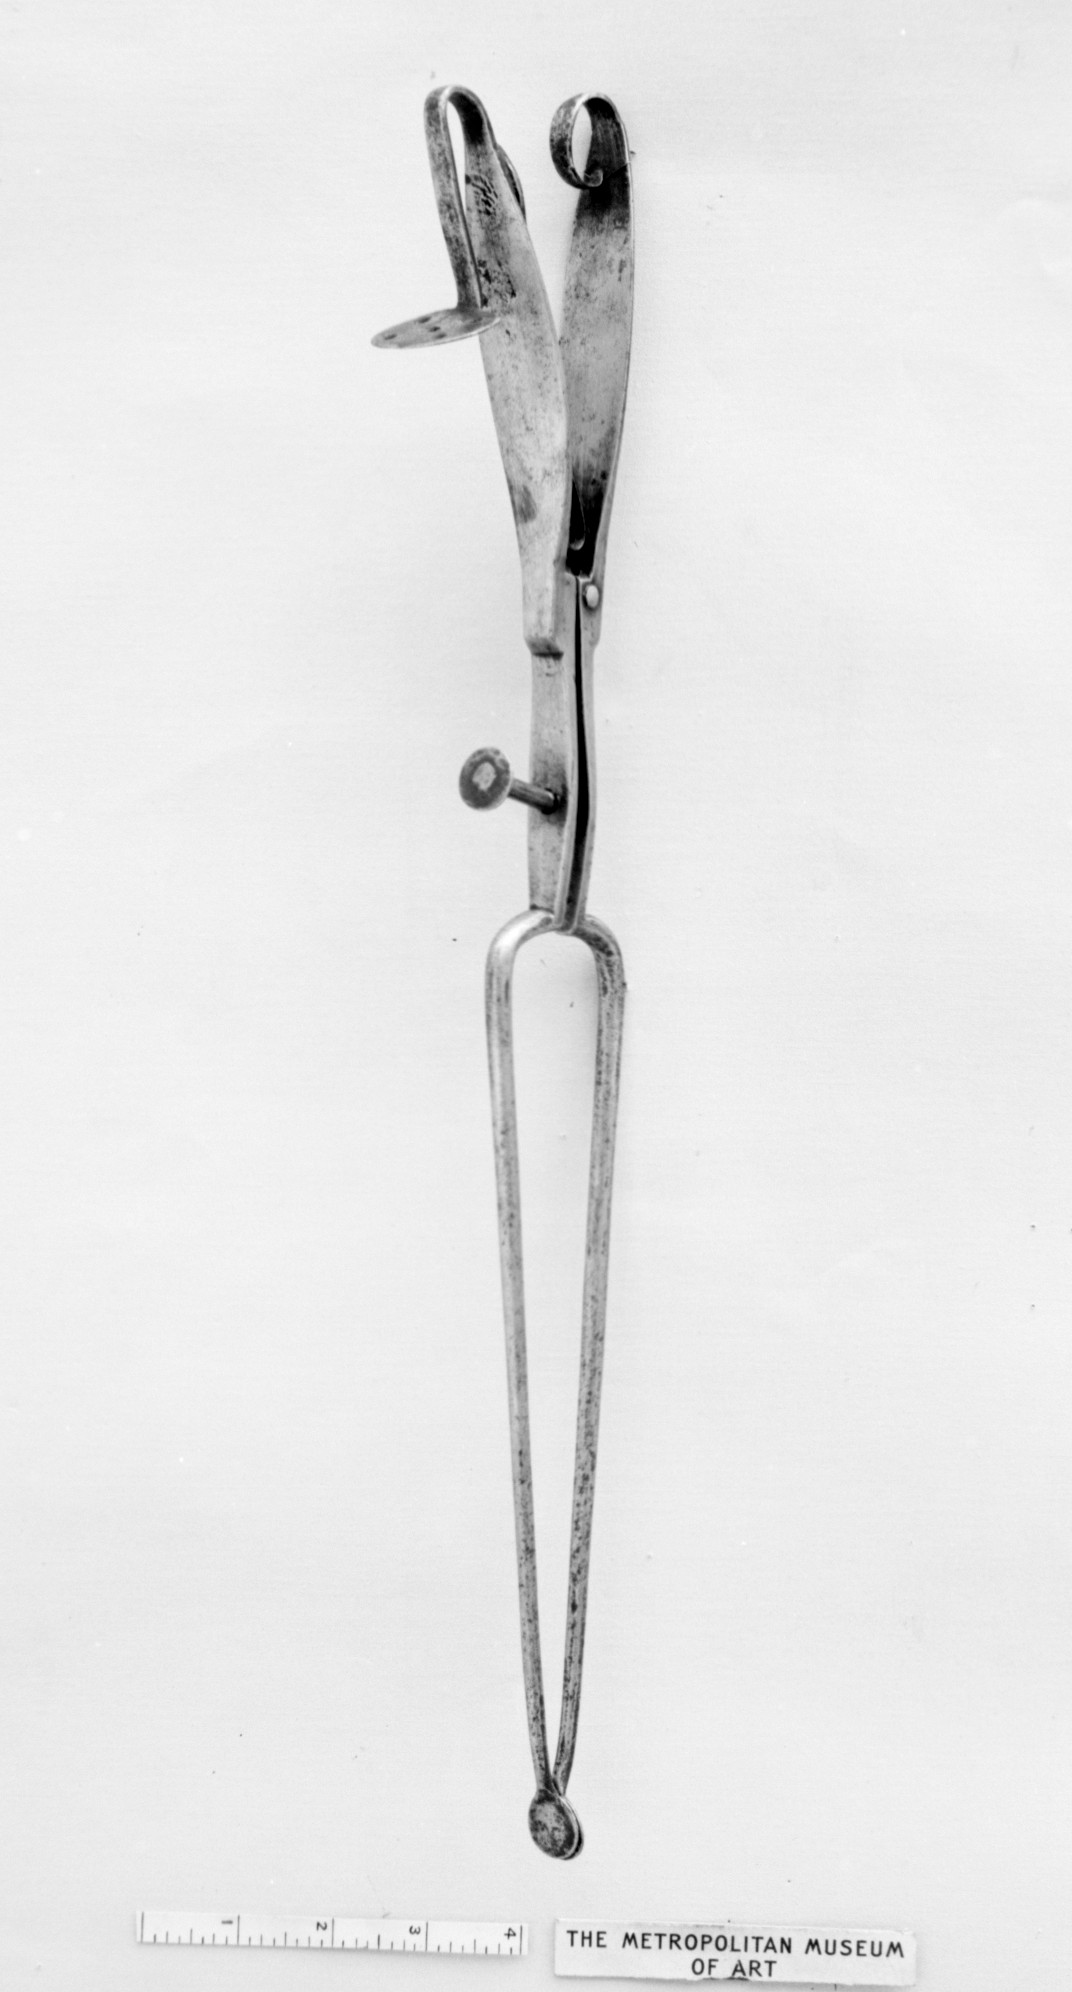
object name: smoker's tongs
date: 1701-1800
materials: iron